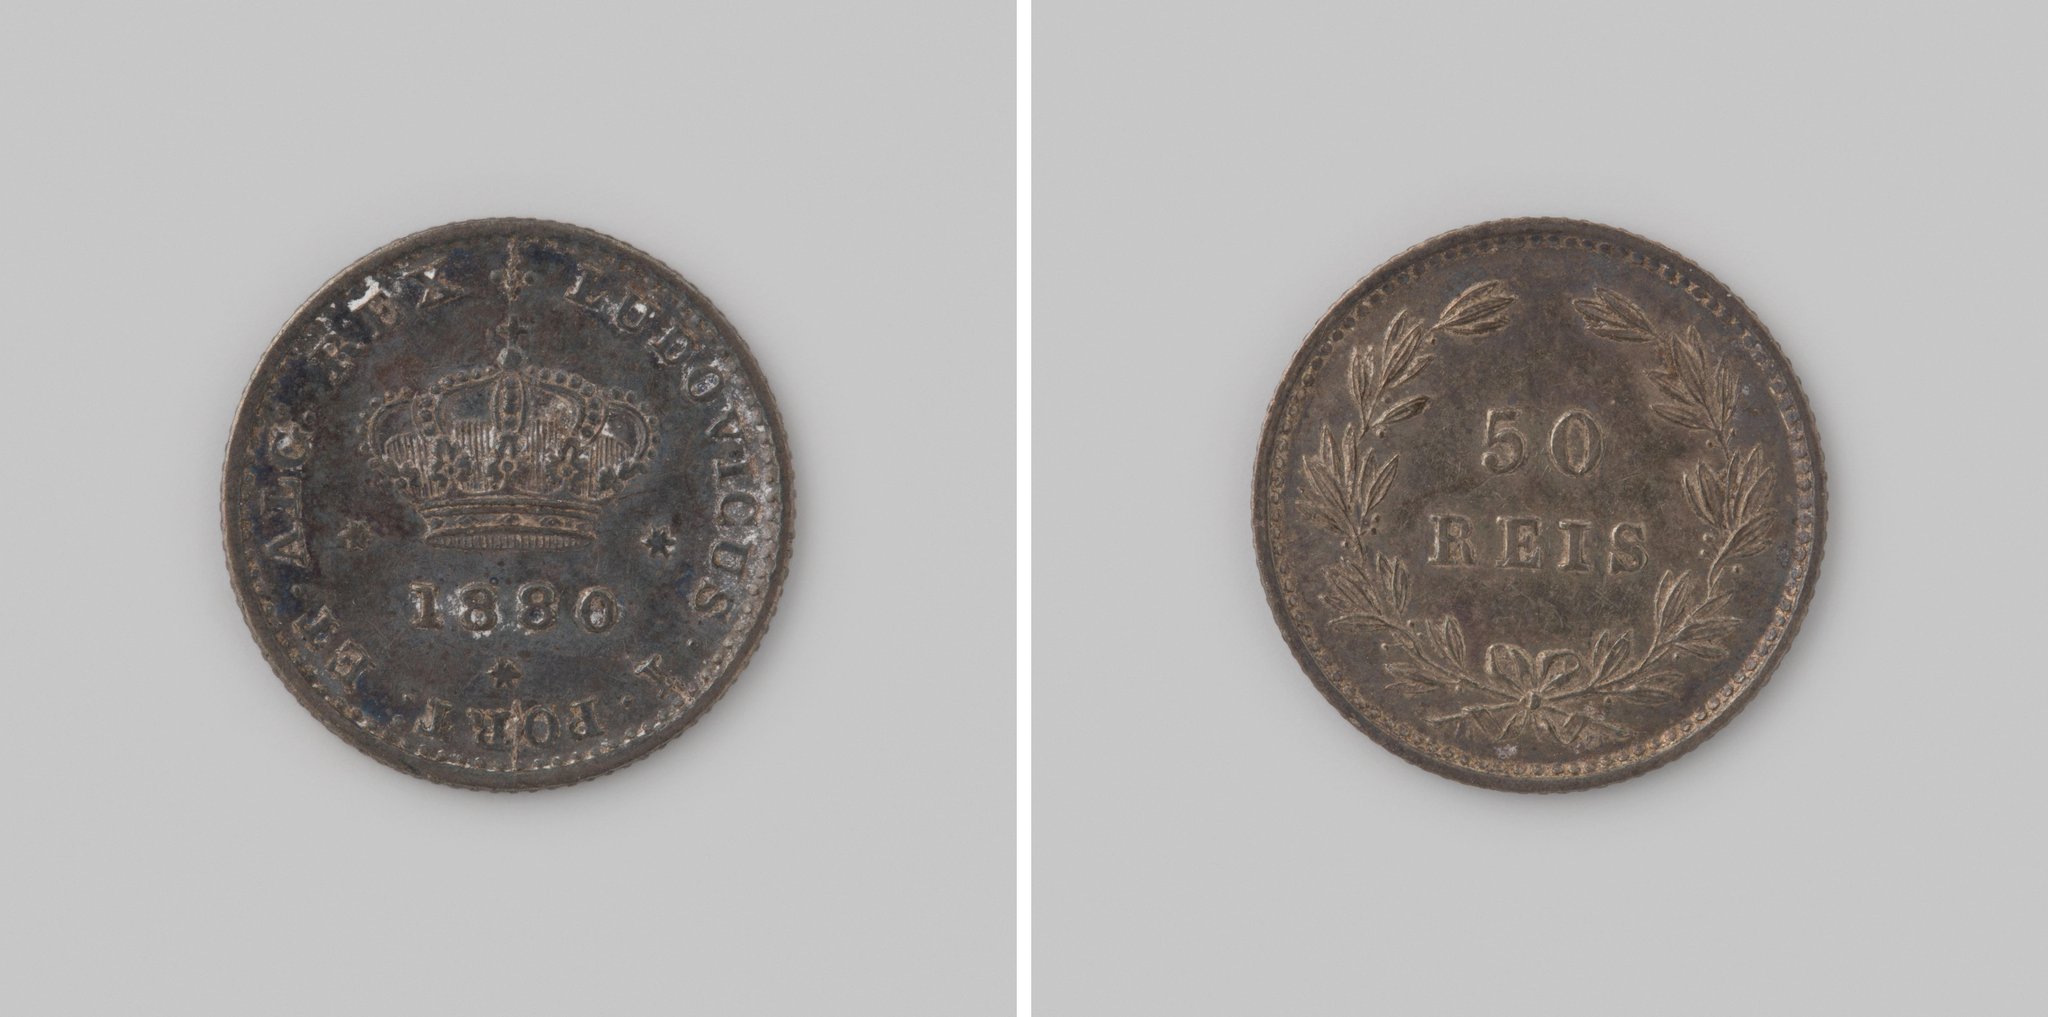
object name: coin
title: Portugal, koning Luiz I, 50 reis, 1880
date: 1880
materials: silver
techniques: striking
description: Zilveren munt. Voorzijde: kroon, waaronder jaartal. Keerzijde: tussen twee samengebonden takken waarde-aanduiding in twee regels. Kartelrand.